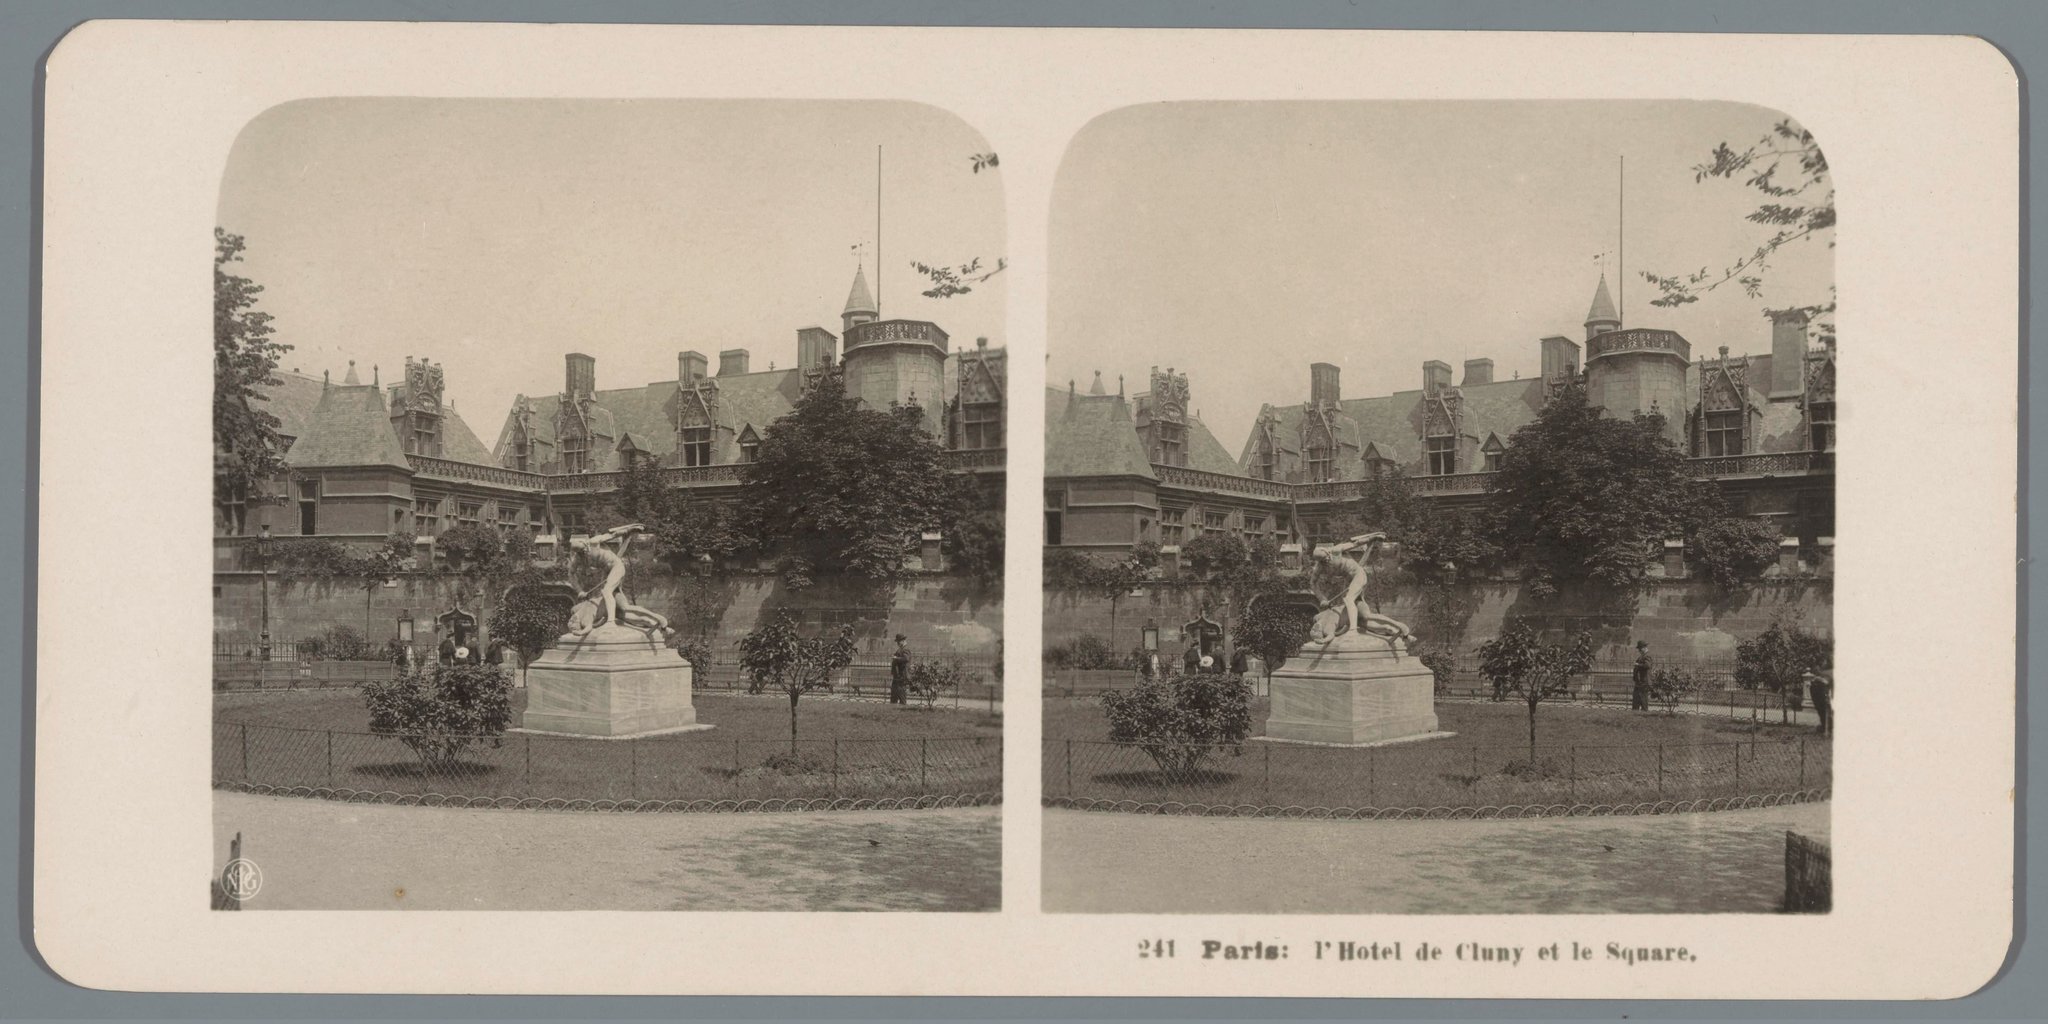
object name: stereograph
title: Paris: l 'Hotel de Cluny et le Square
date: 1895-1905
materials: cardboard, photographic support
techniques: gelatin silver print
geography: paris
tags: permanent exhibition, museum, sculpture, façade (of house or building)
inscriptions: number: ‘241’, inscription: ‘NPG’